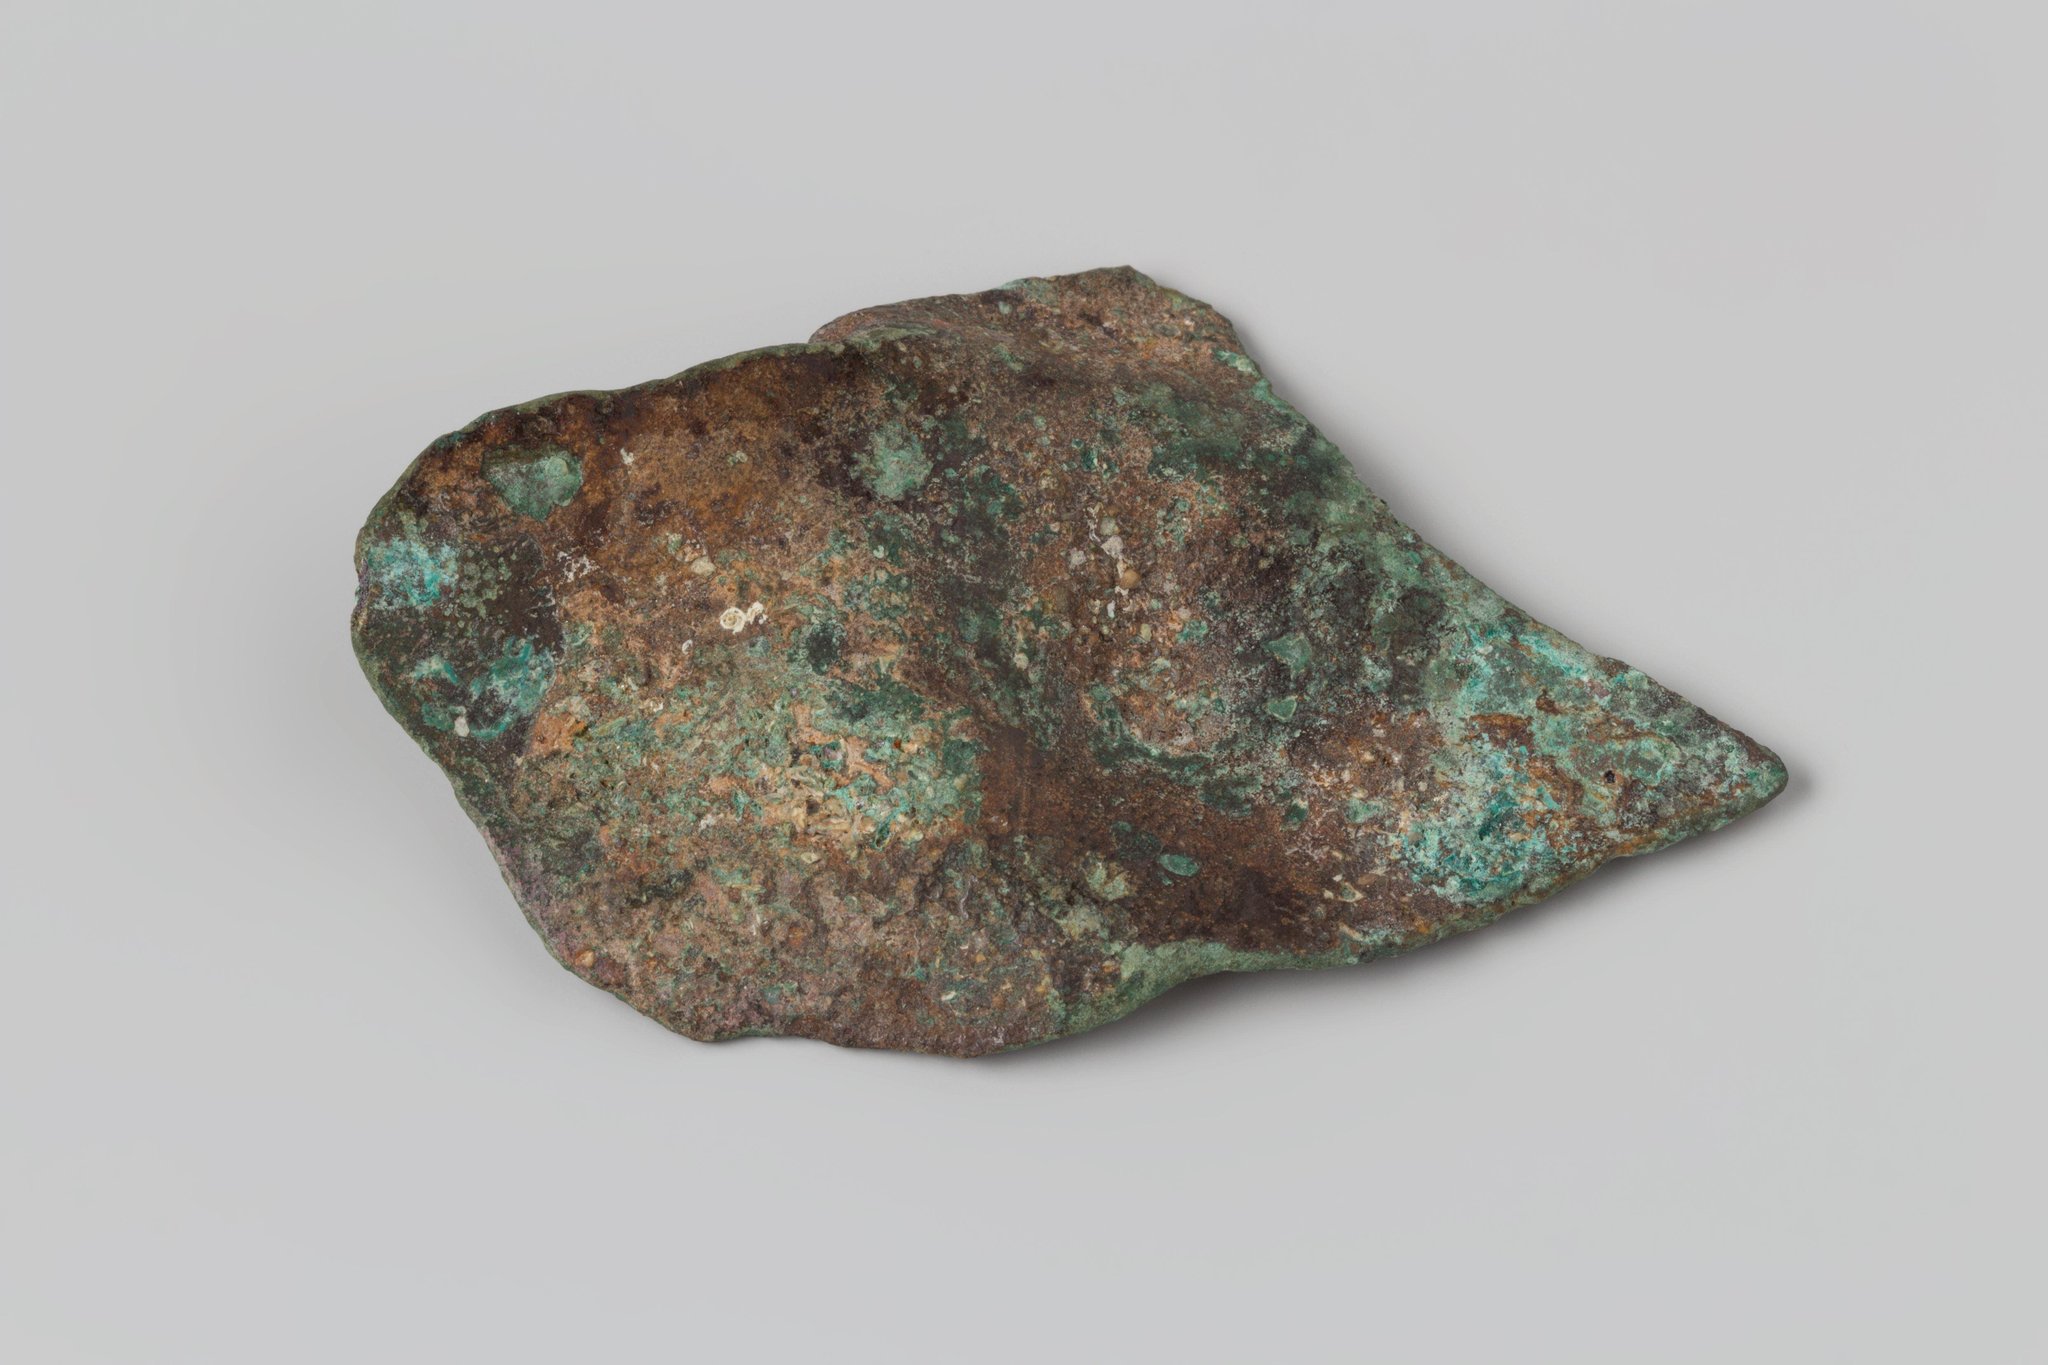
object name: scheepswrakvondst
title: Fragment van koper uit het wrak van de Oost-Indiëvaarder Hollandia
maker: Anonymous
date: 1700-1743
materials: copper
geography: netherlands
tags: verenigde oostindische compagnie, hollandia (schip), annet